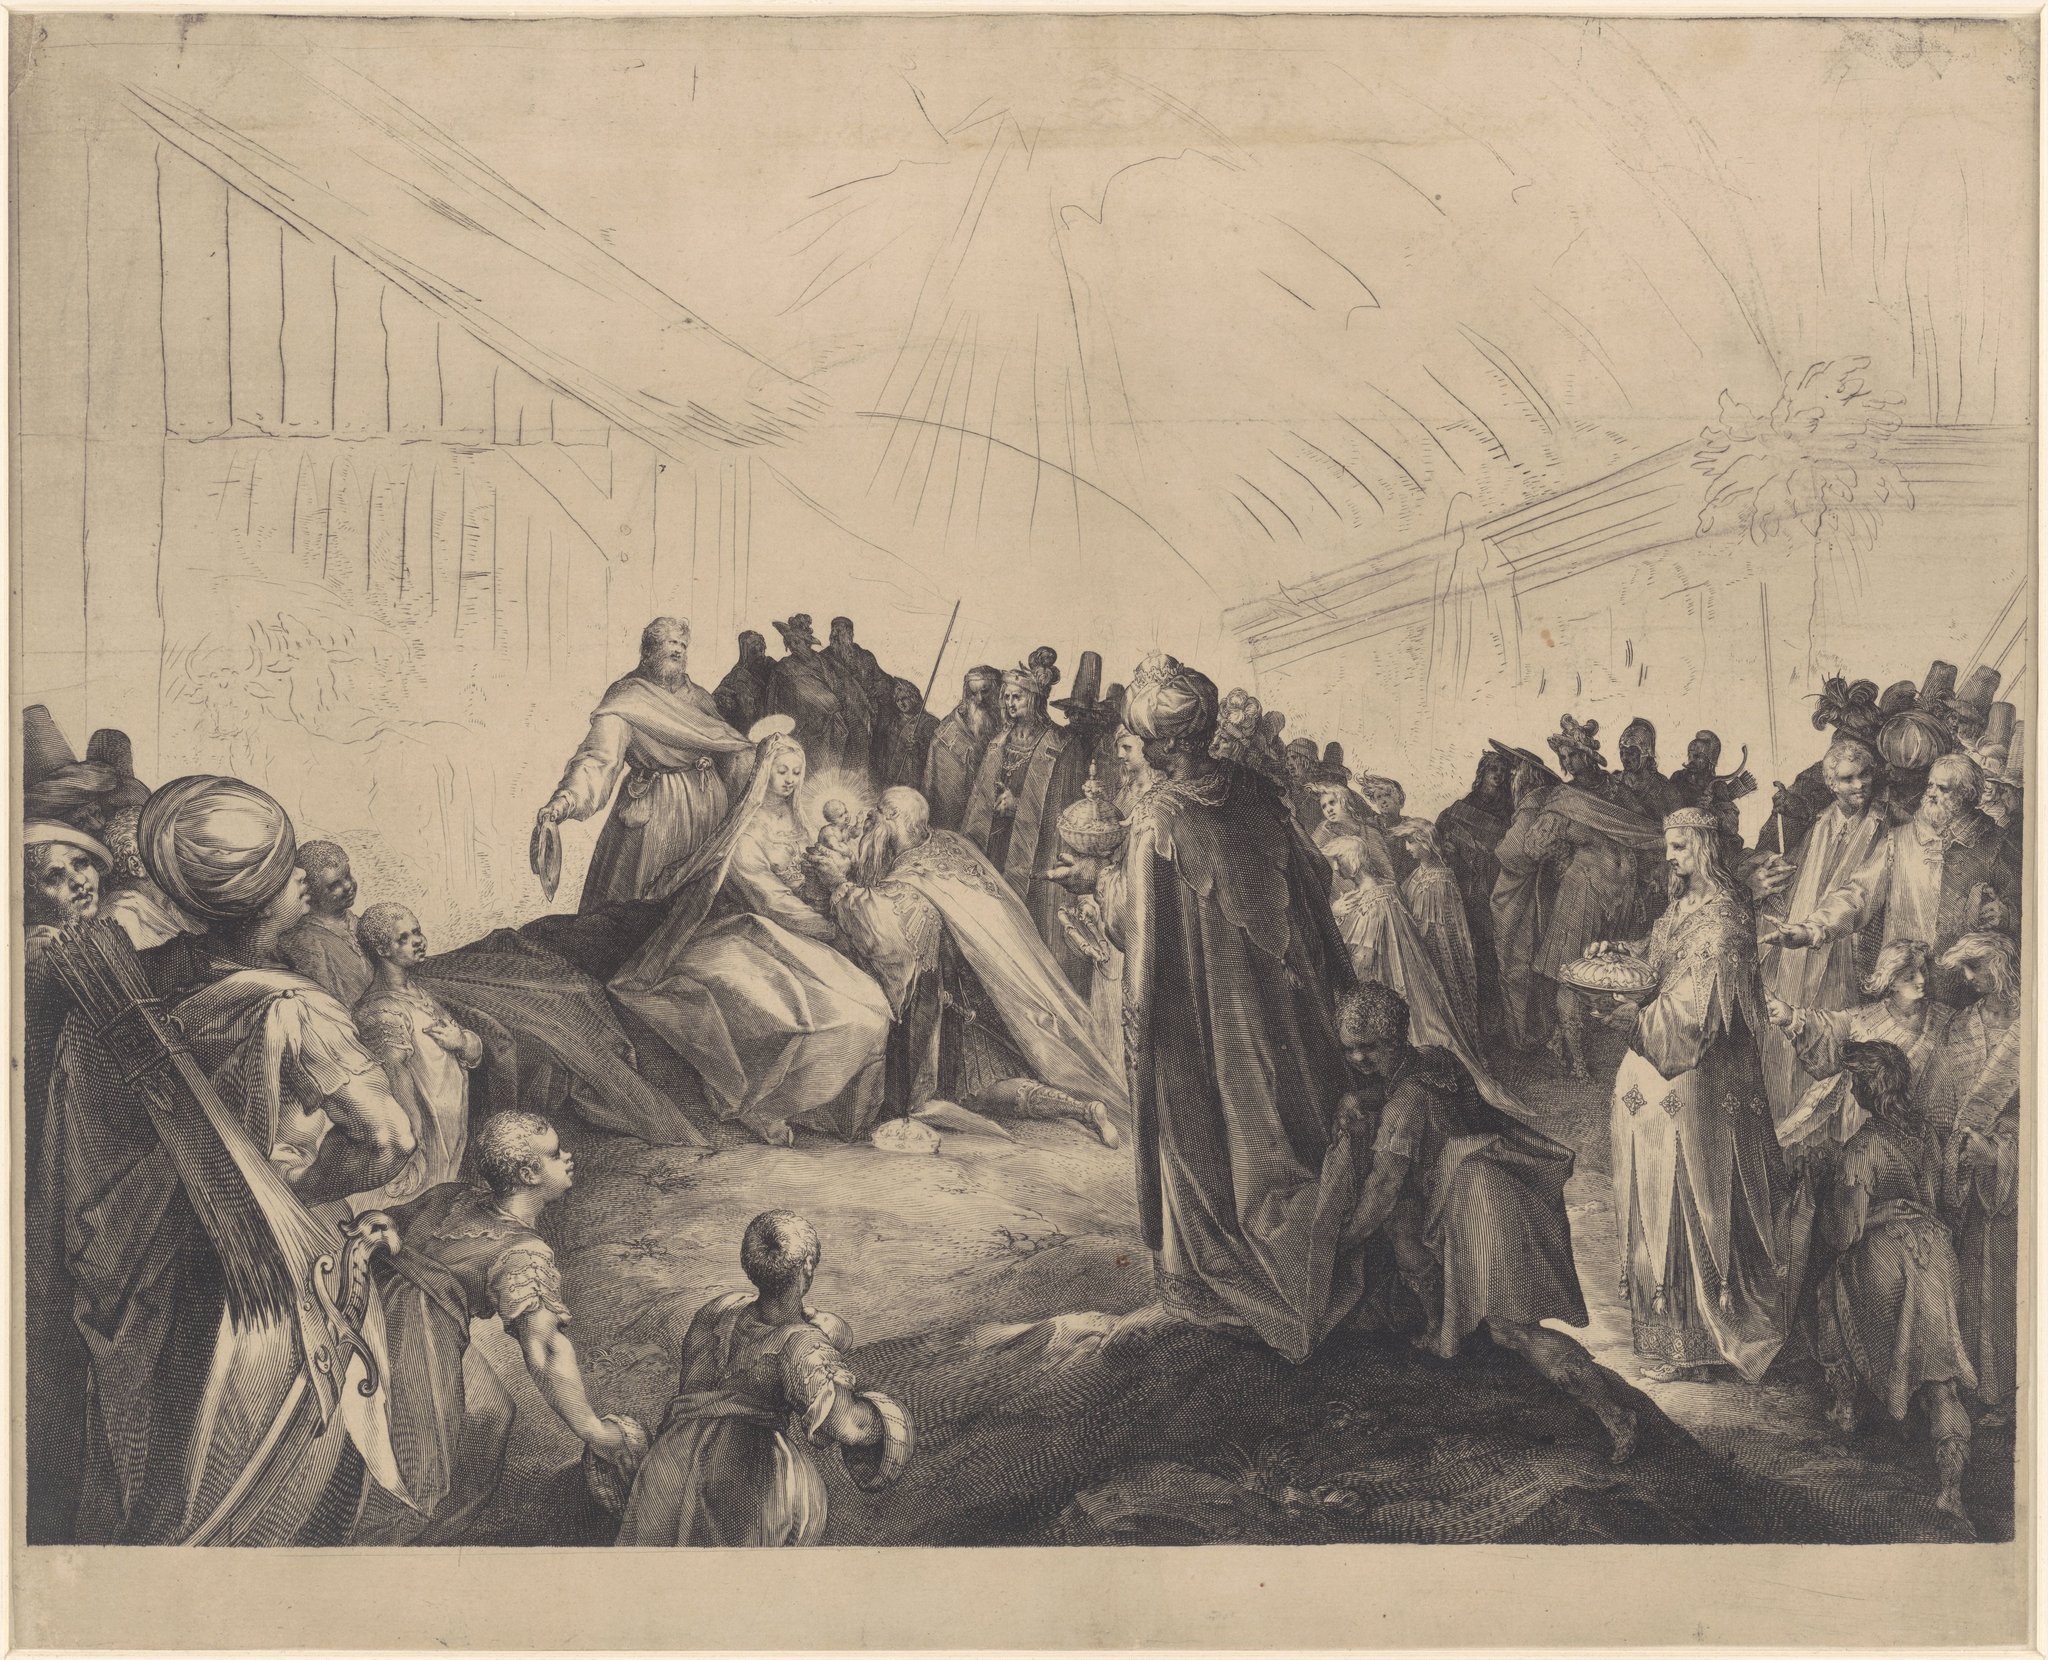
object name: print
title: Aanbidding door de koningen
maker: jan harmensz. muller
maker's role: draughtsman, print maker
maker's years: 1571-1628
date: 1598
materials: paper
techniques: drypoint, engraving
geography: amsterdam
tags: adoration of the kings: the wise men present their gifts to the christ-child (gold, frankincense and myrrh)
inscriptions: collector's mark: Lugt 240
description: De drie koningen en hun gevolg aanbidden het Christuskind. Een koning knielt voor het Kind.